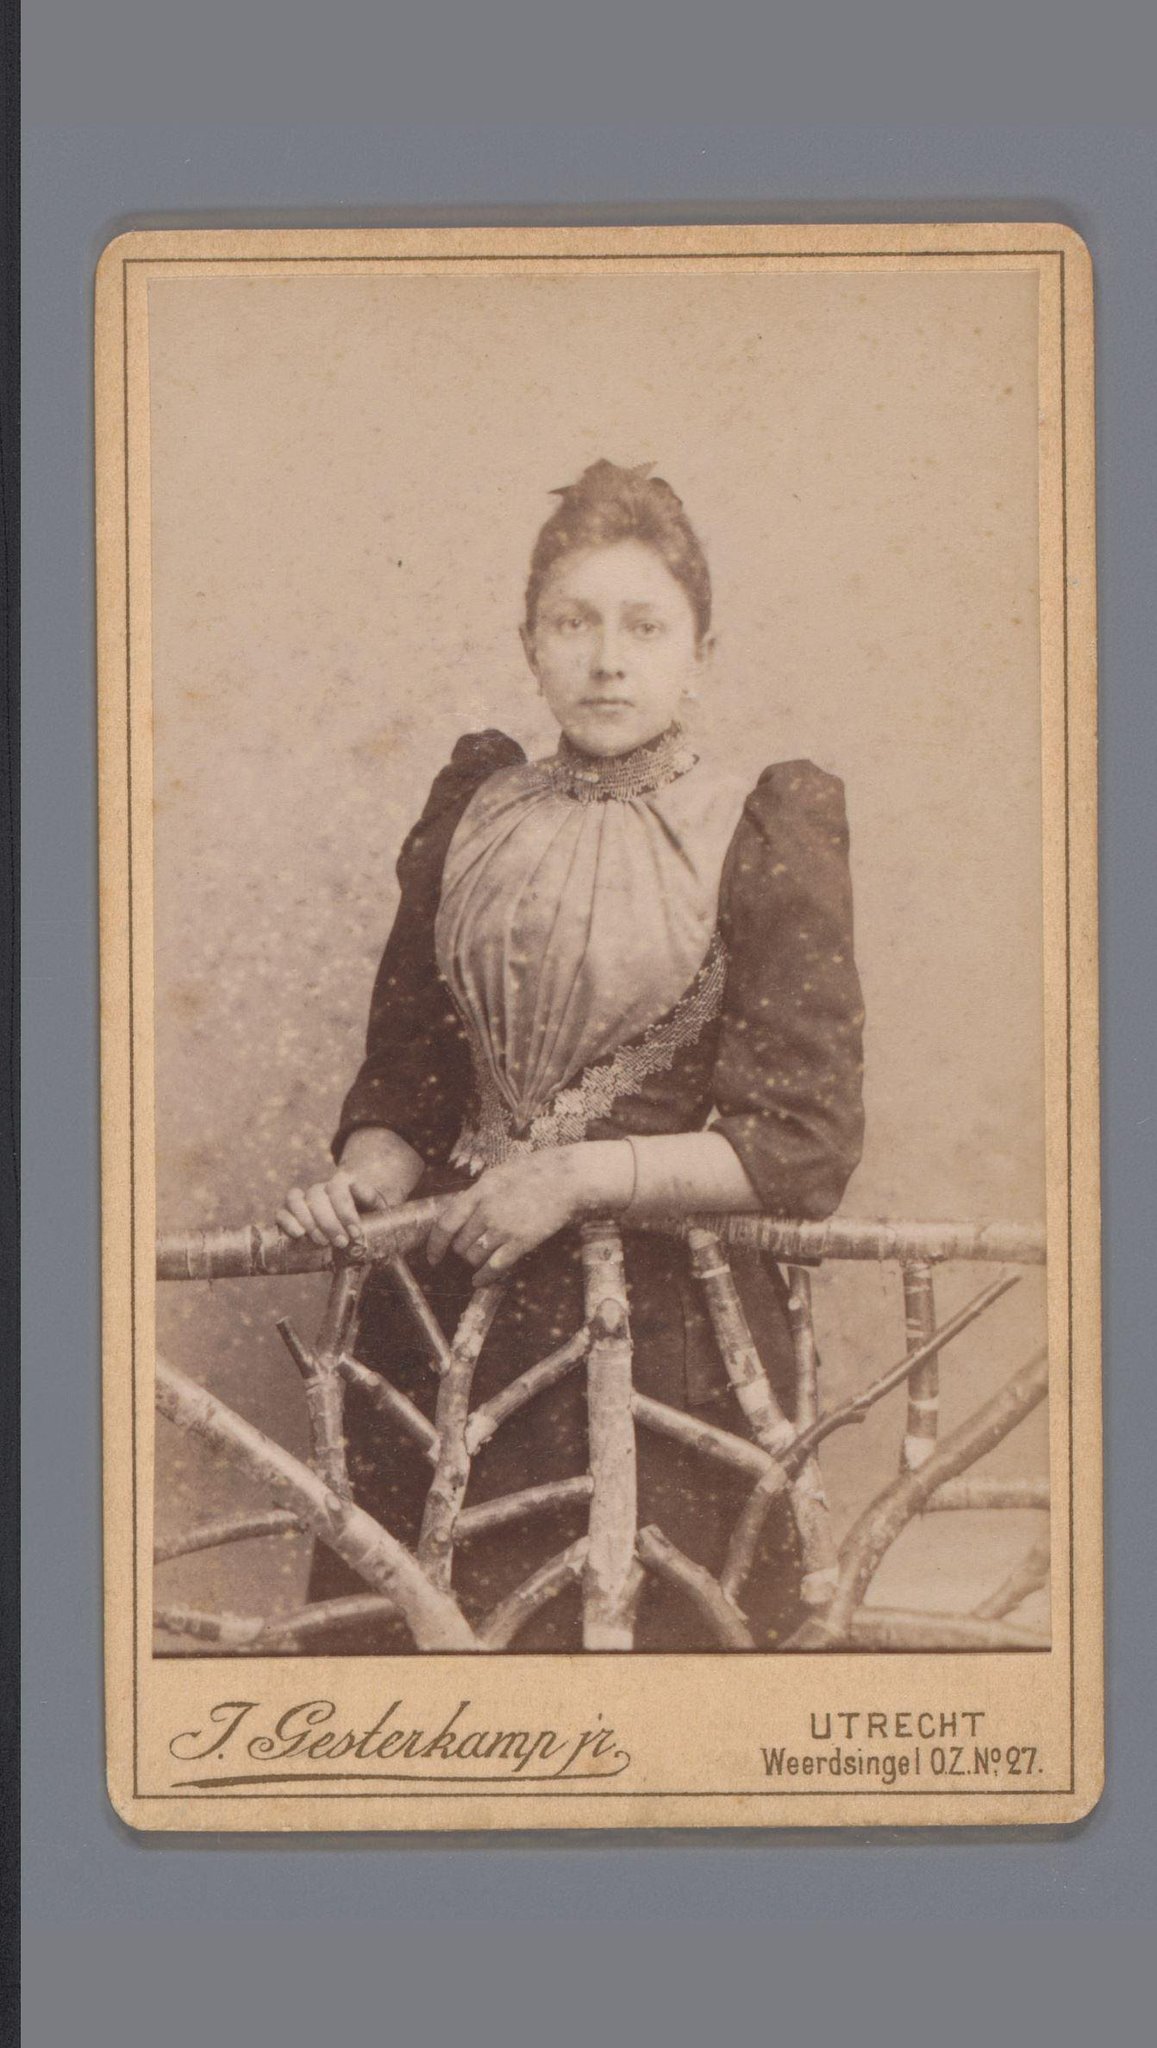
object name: carte de visite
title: Portret van een onbekende vrouw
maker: johannes gesterkamp jr.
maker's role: painter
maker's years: 1859-1937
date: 1886-1901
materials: cardboard, paper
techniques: albumen print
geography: utrecht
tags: adult woman, anonymous historical person portrayed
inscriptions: address: ‘Weerdsingel O.Z. No 27/ tusschen de Weerd en Noorderbruggen.’, inscription: ‘Specialiteit in Kooldruk-Vergrootingen./ De platen worden voor nabestelling bewaard.’